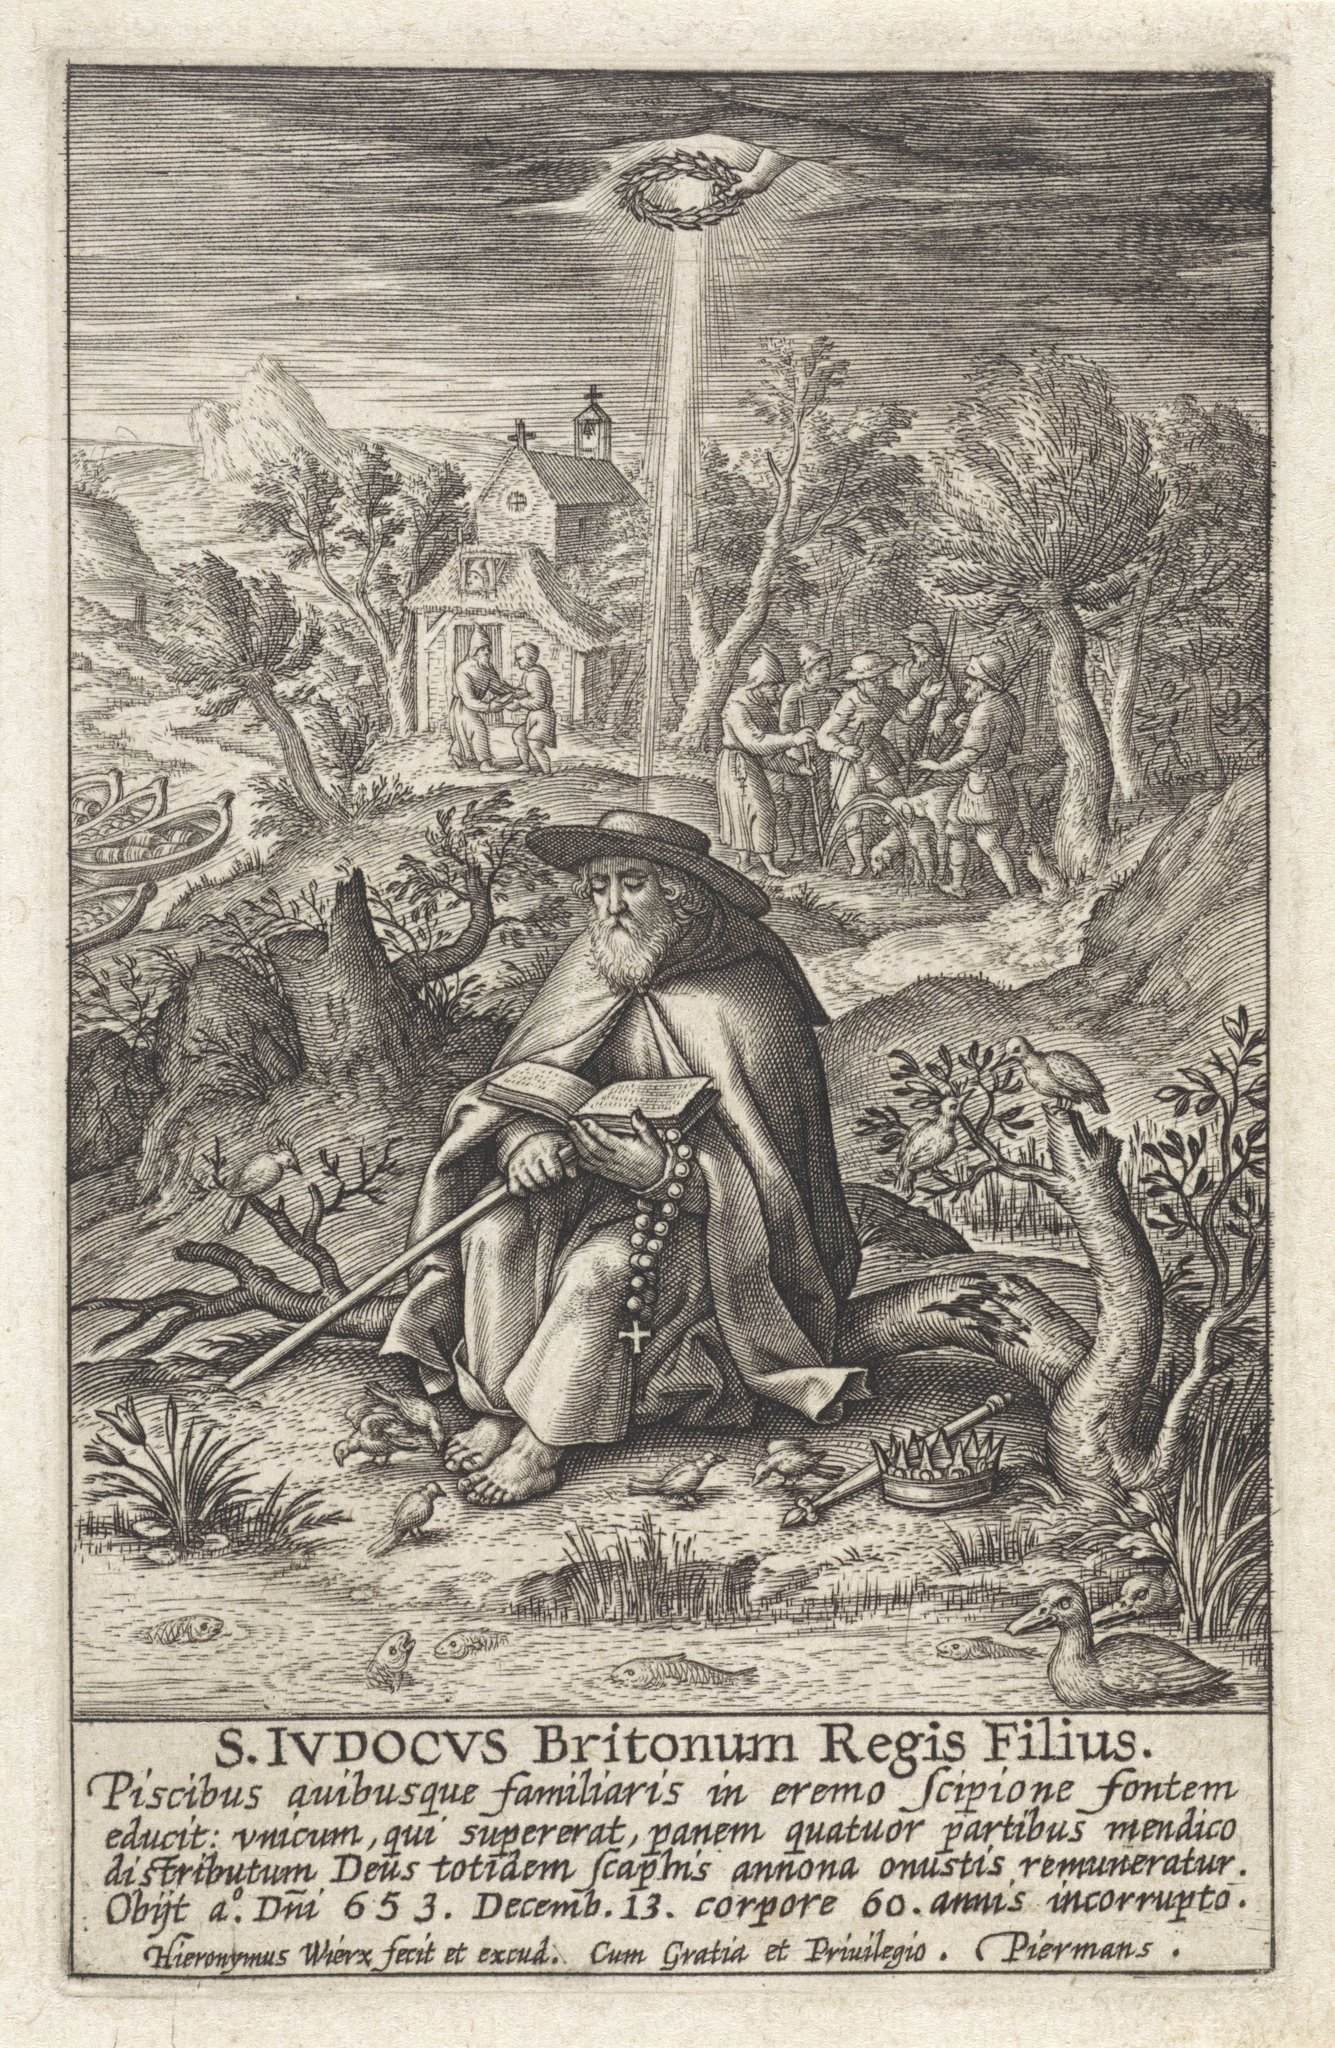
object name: print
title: Landschap met de H. Jodocus van Ponthieu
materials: paper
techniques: engraving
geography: antwerp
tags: the hermit, pilgrim, and erstwhile prince of brittany, judoc (josse) of ponthieu; possible attributes: crown in hand or at feet - miraculous activities and events ~ male saint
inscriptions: collector's mark: Lugt 2228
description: De heilige Jodocus, zoon van een Bretonse koning, zit aan de rand van de bron die hij met zijn stok heeft doen ontstaan. Aan zijn voeten liggen zijn kroon en scepter. Vanuit de hemel laat een hand een lauwerkrans afdalen. In het landschap op de achtergrond scènes uit zijn leven. In de marge een vierregelig onderschrift in het Latijn.